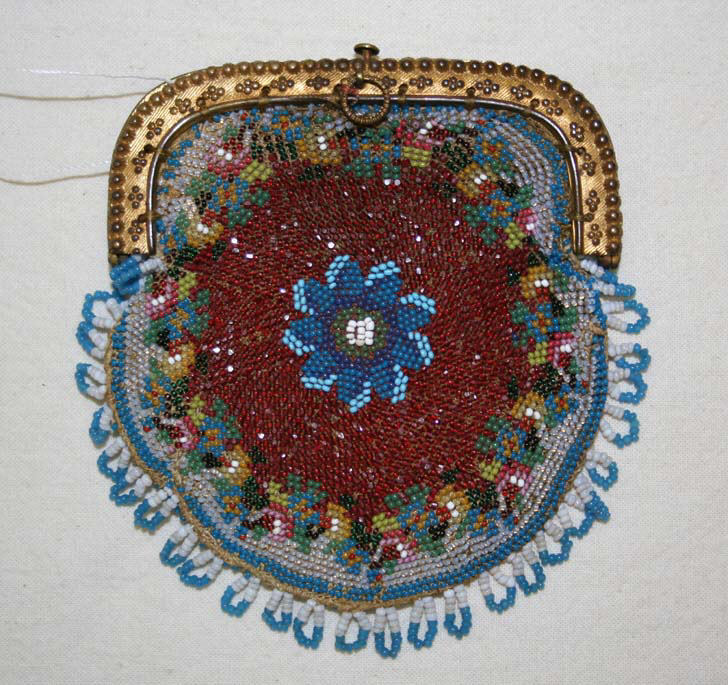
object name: purse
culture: german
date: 1840-1849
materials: glass, metal, silk